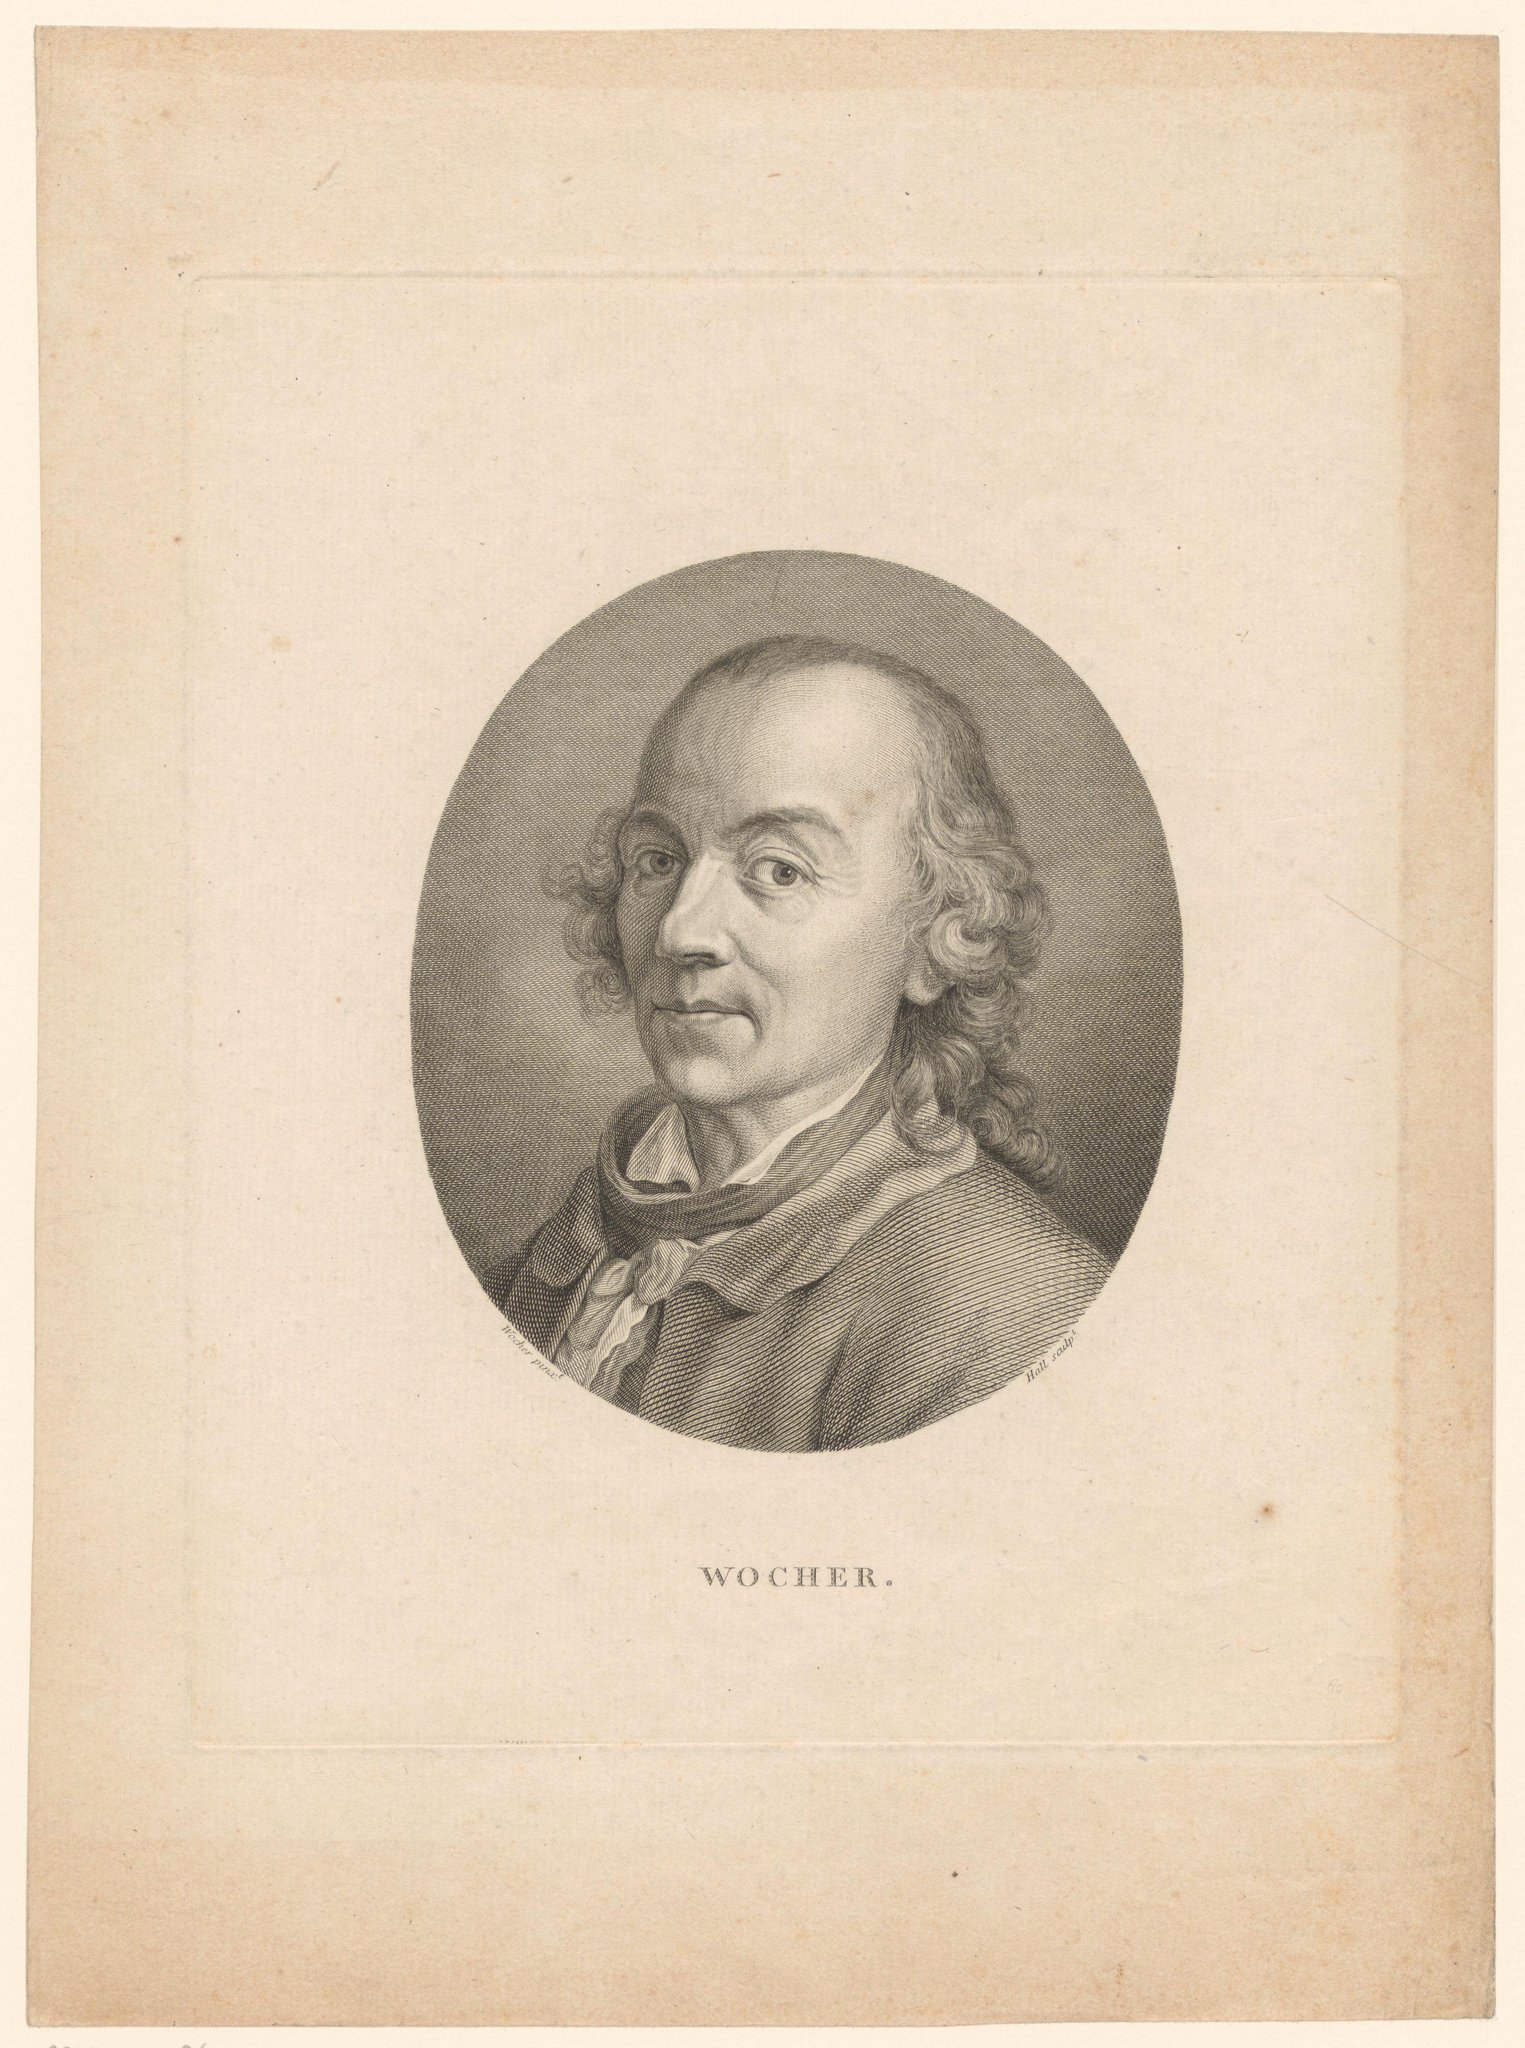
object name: print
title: Wocher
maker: john hall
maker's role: print maker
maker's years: 1739-1797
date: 1768-1797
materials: paper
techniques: engraving, etching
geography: great britain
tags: painter, tiberius dominikus wocher, historical persons, portrait, self-portrait of painter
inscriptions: collector's mark: Lugt 2228